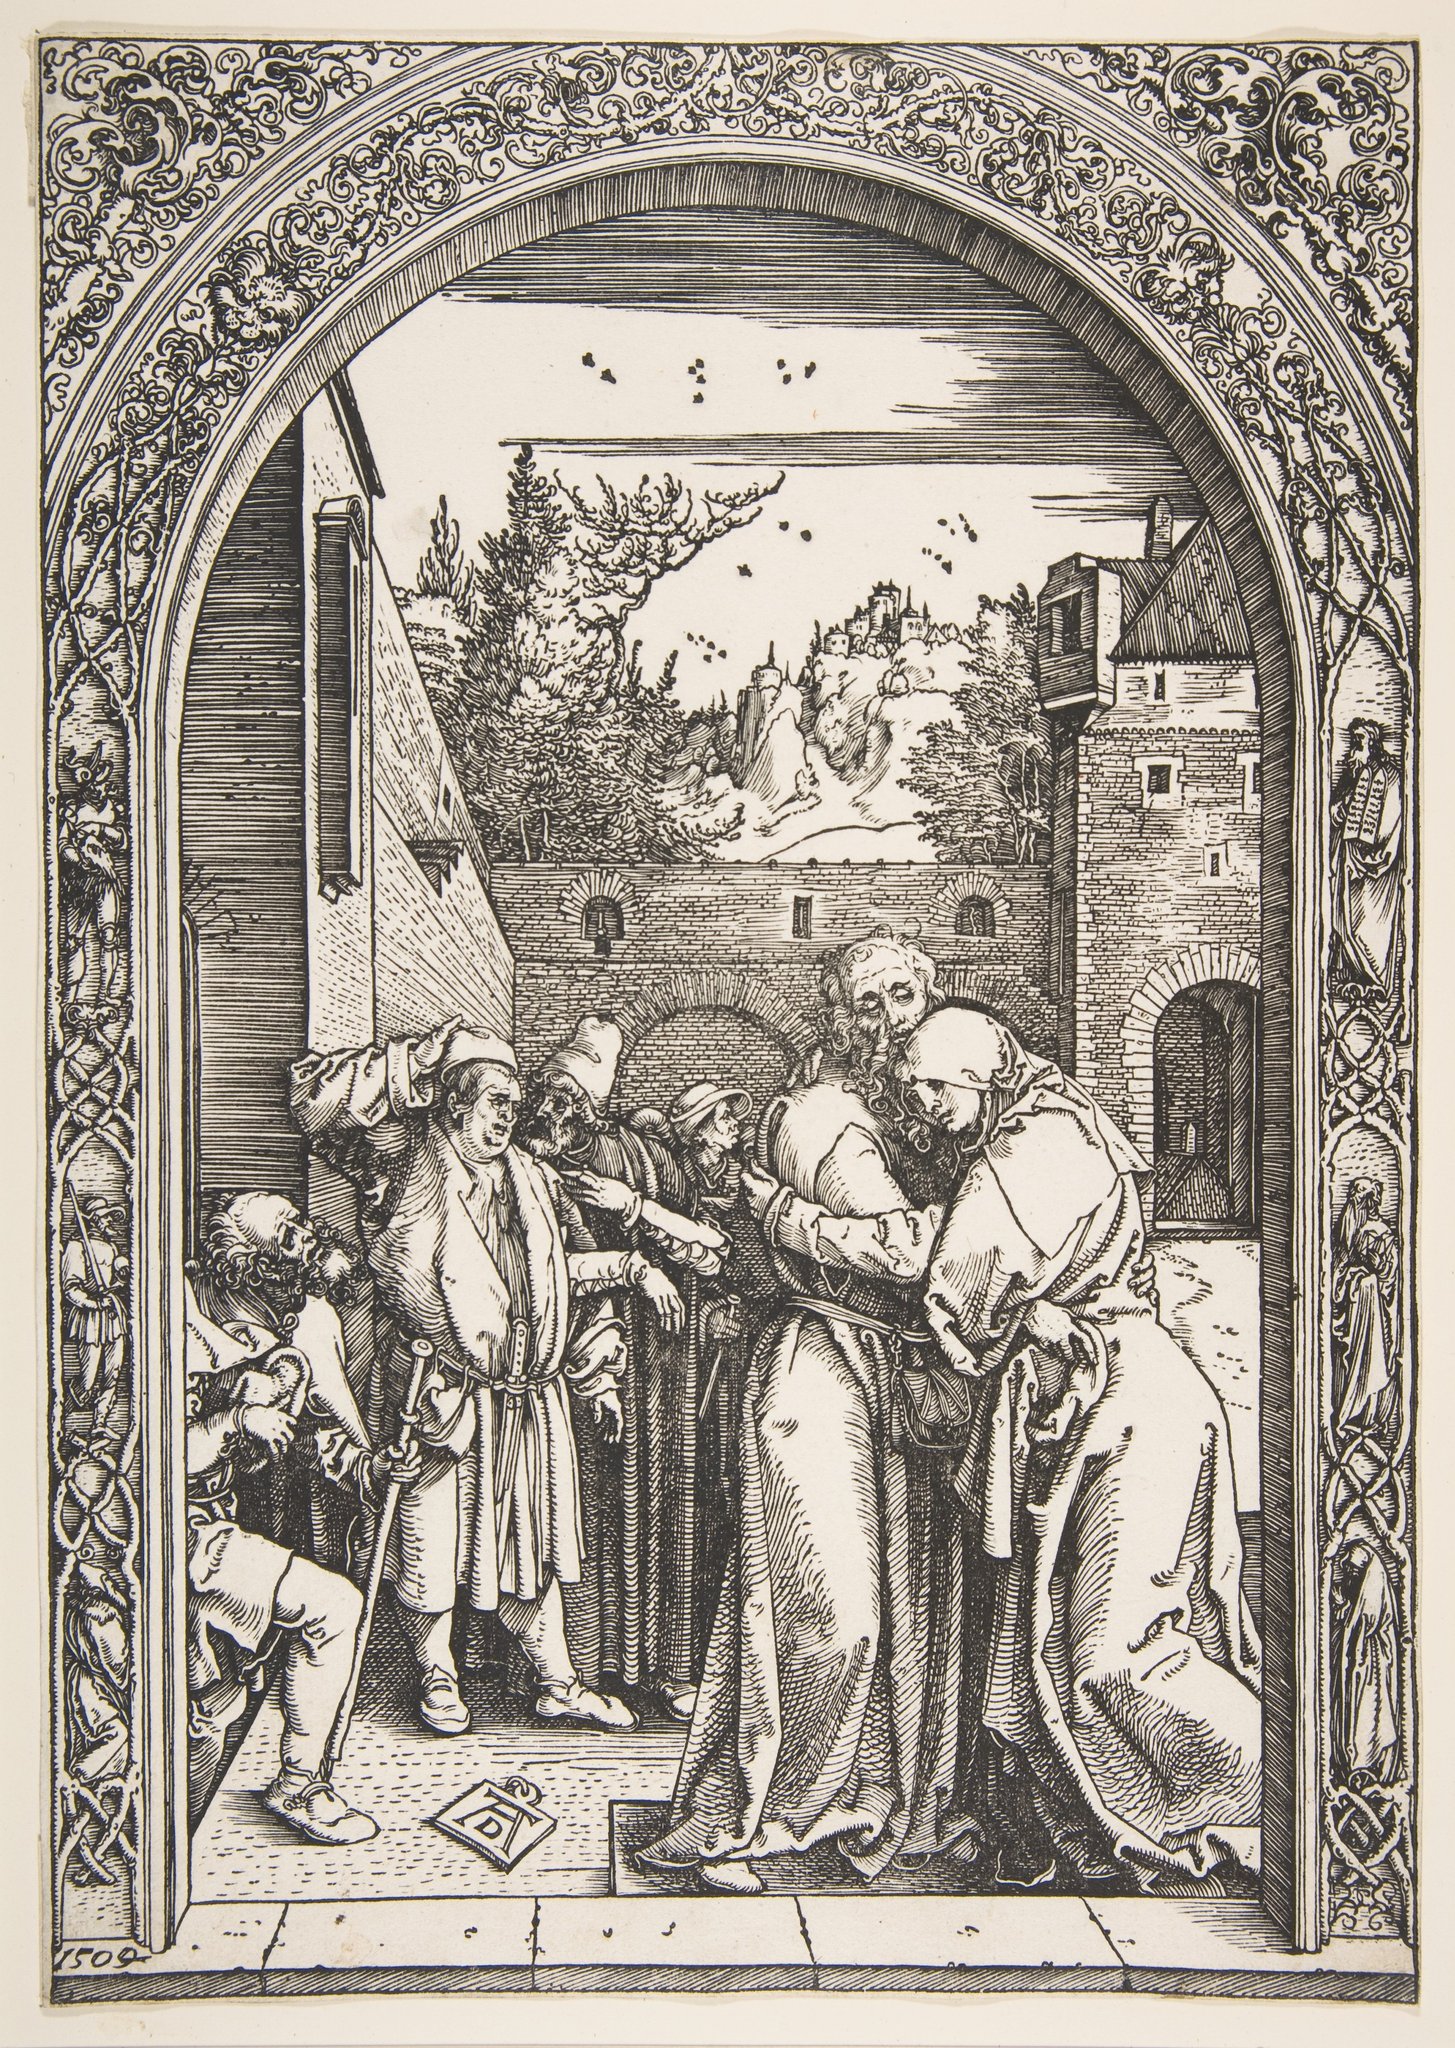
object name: print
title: Joachim and Anna at the Golden Gate, from "The Life of the Virgin"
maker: albrecht dürer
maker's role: artist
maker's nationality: german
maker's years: 1471-1528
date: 1504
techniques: woodcut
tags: men,women